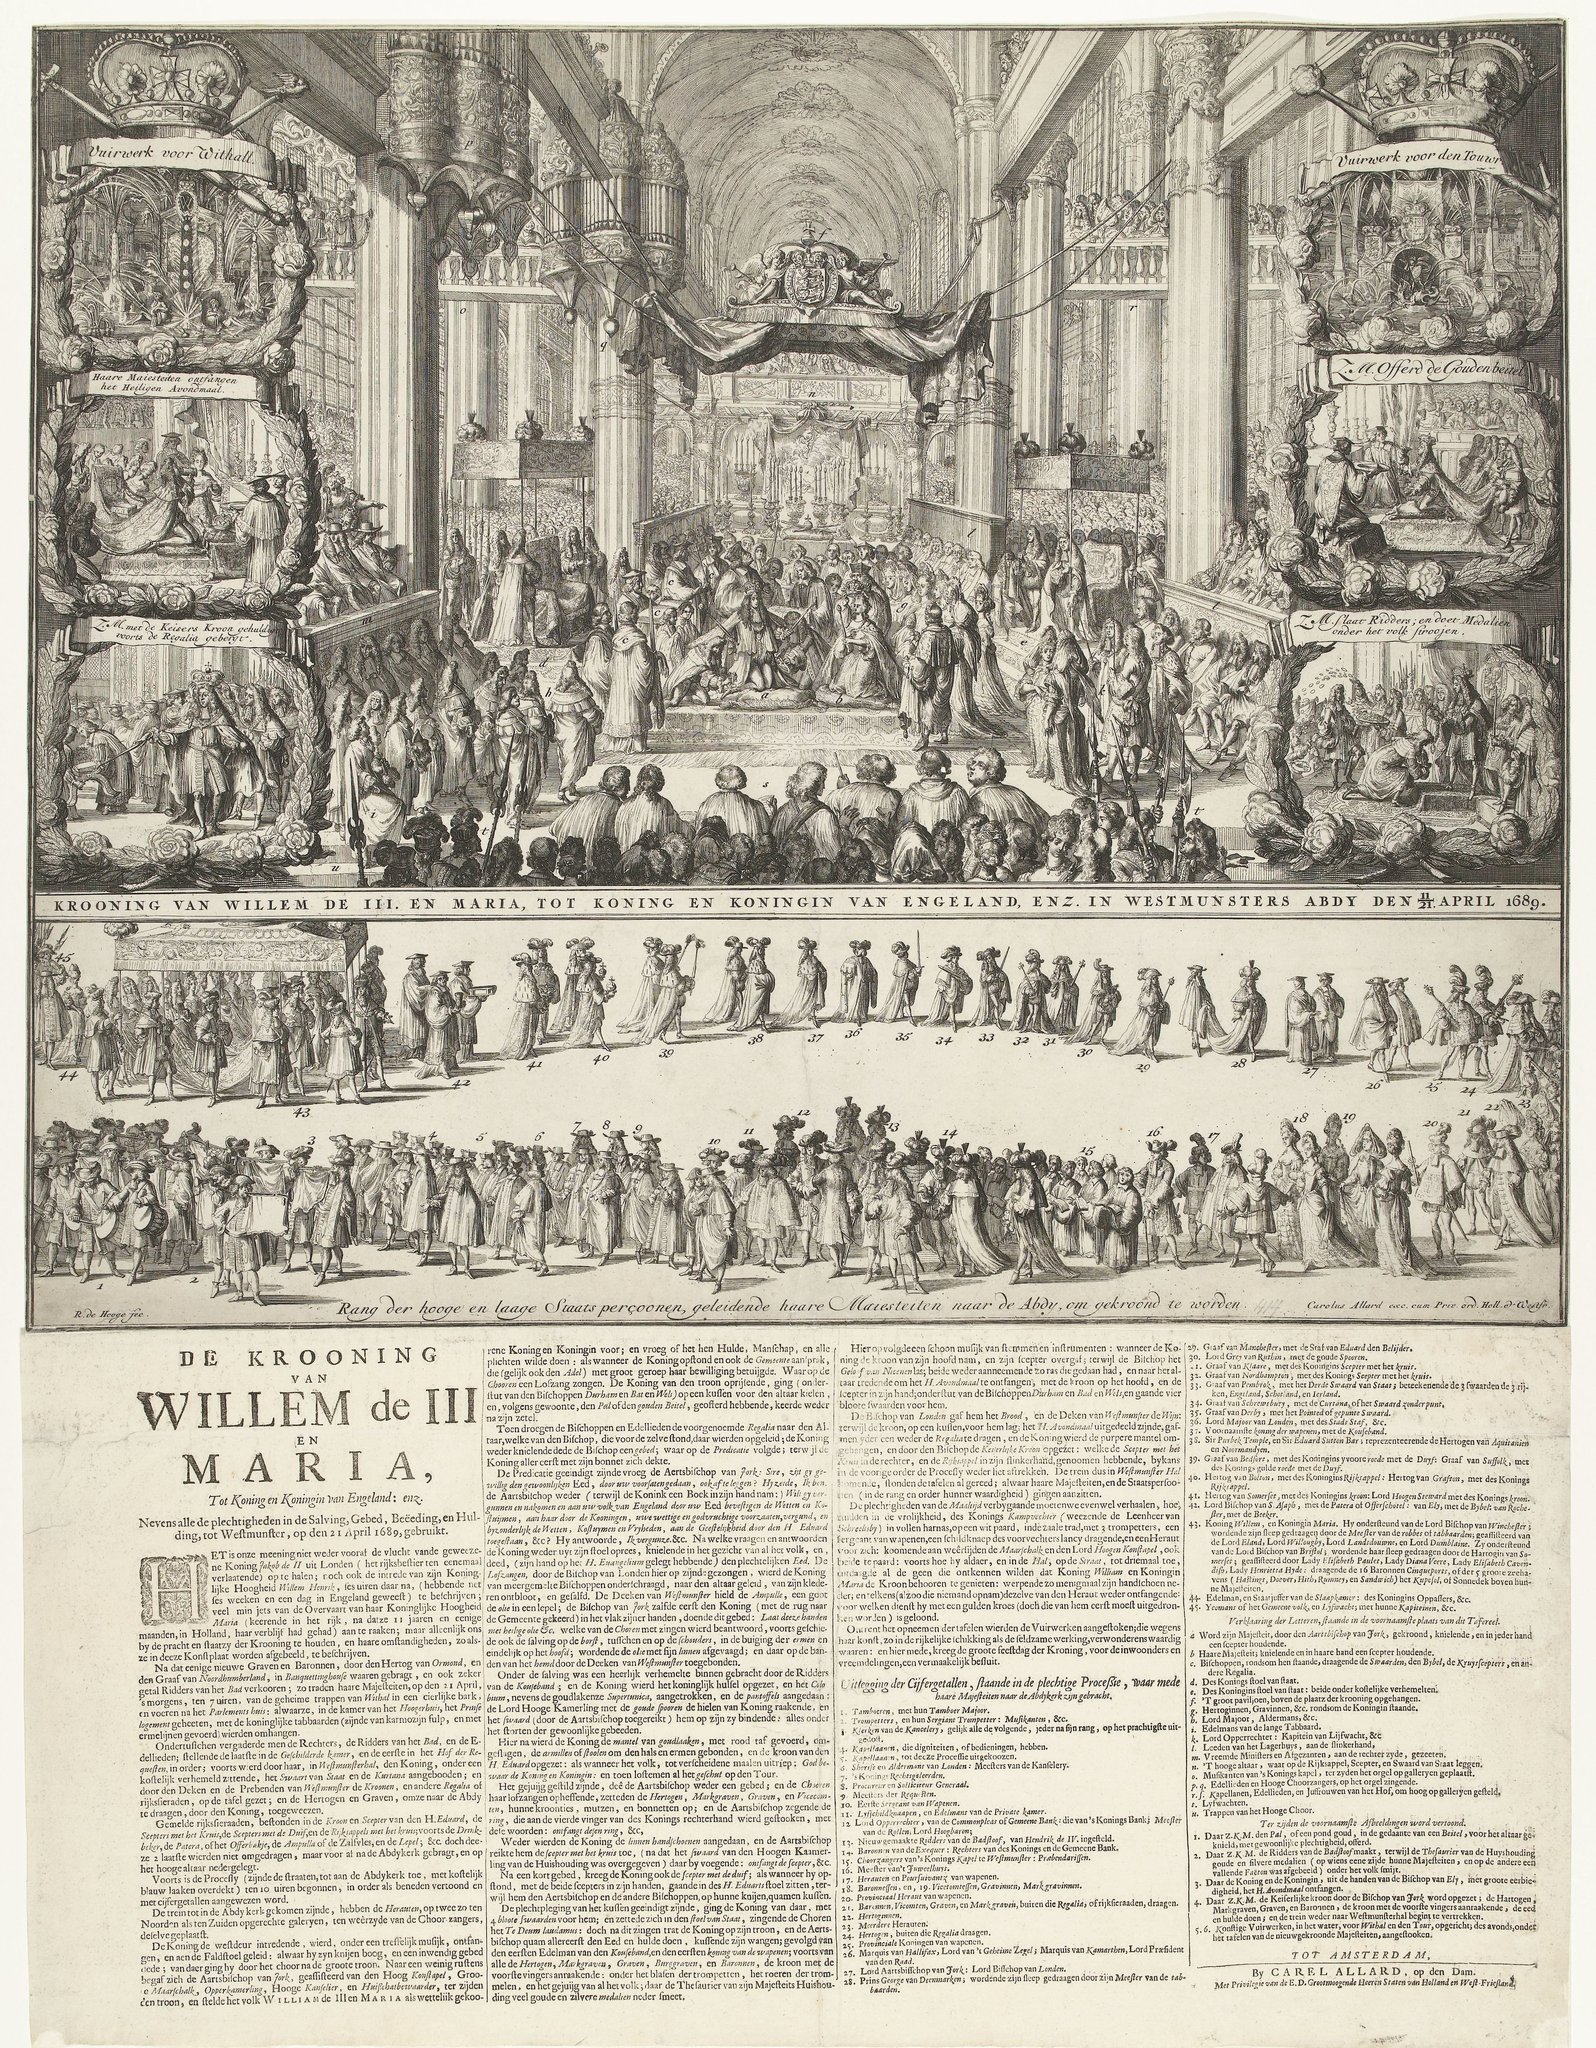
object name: print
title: Krooning van Willem de III. en Maria, tot koning en koningin van Engeland, enz. in Westmunsters Abdy den 11/21 April 1689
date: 1689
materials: paper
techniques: etching, letterpress printing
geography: amsterdam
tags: the hague, william iii (prince of orange and king of england, scotland, and ireland), london, maria ii stuart (koningin van engeland, schotland en ierland), coronation of a ruler, festivities (+ parade, pageant, cavalcade ~ festive activities), westminster abbey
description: Kroning van Willem en Maria tot koning en koningin van Engeland in de Westminster Abbey, 21 april 1689. Uitvoerige voorstelling van de kroningsceremonie in de kerk met aan weerszijden drie kleine scènes van belangrijke momenten uit de plechtigheid. Hieronder een aparte voorstelling van de processie. Vastgeplakt onder de prent een tekstblad met een beschrijving van de gebeurtenissen en de legenda's 1-45 en a-u in 4 kolommen in het Nederlands.